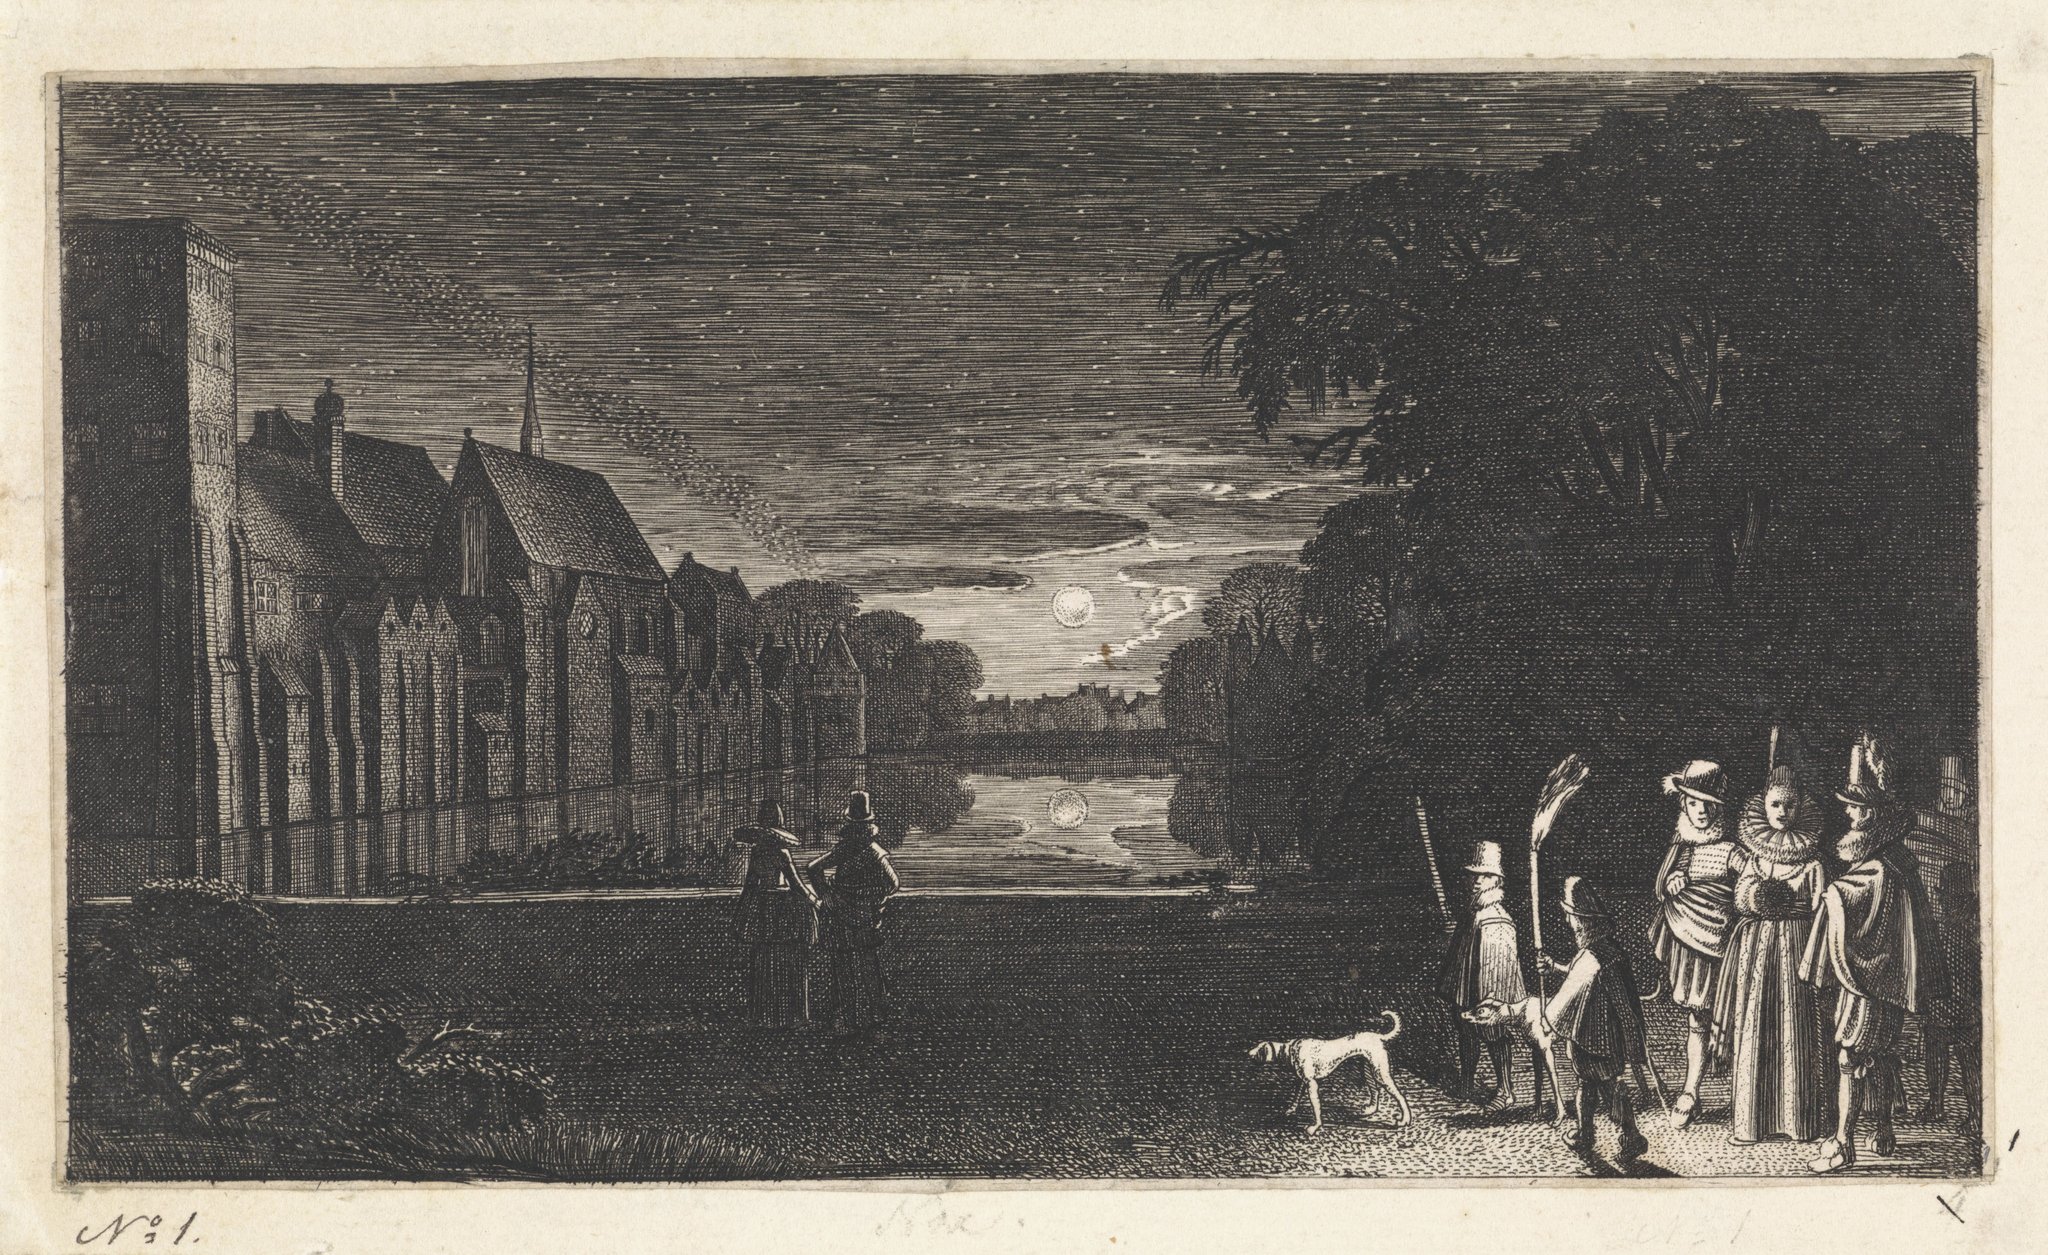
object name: print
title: Nacht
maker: jan van de velde (ii)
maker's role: draughtsman, painter, print maker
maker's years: 1593-1641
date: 1603-1641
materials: paper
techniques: engraving, etching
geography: northern netherlands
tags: full moon, torch, night ~ landscape (sometimes titled 'nox'), night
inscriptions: collector's mark: Lugt 964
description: Gezicht op het Buitenhof in Den Haag bij nacht. Rechtsvoor een gezelschap met fakkels. Prent uit een serie van vier.